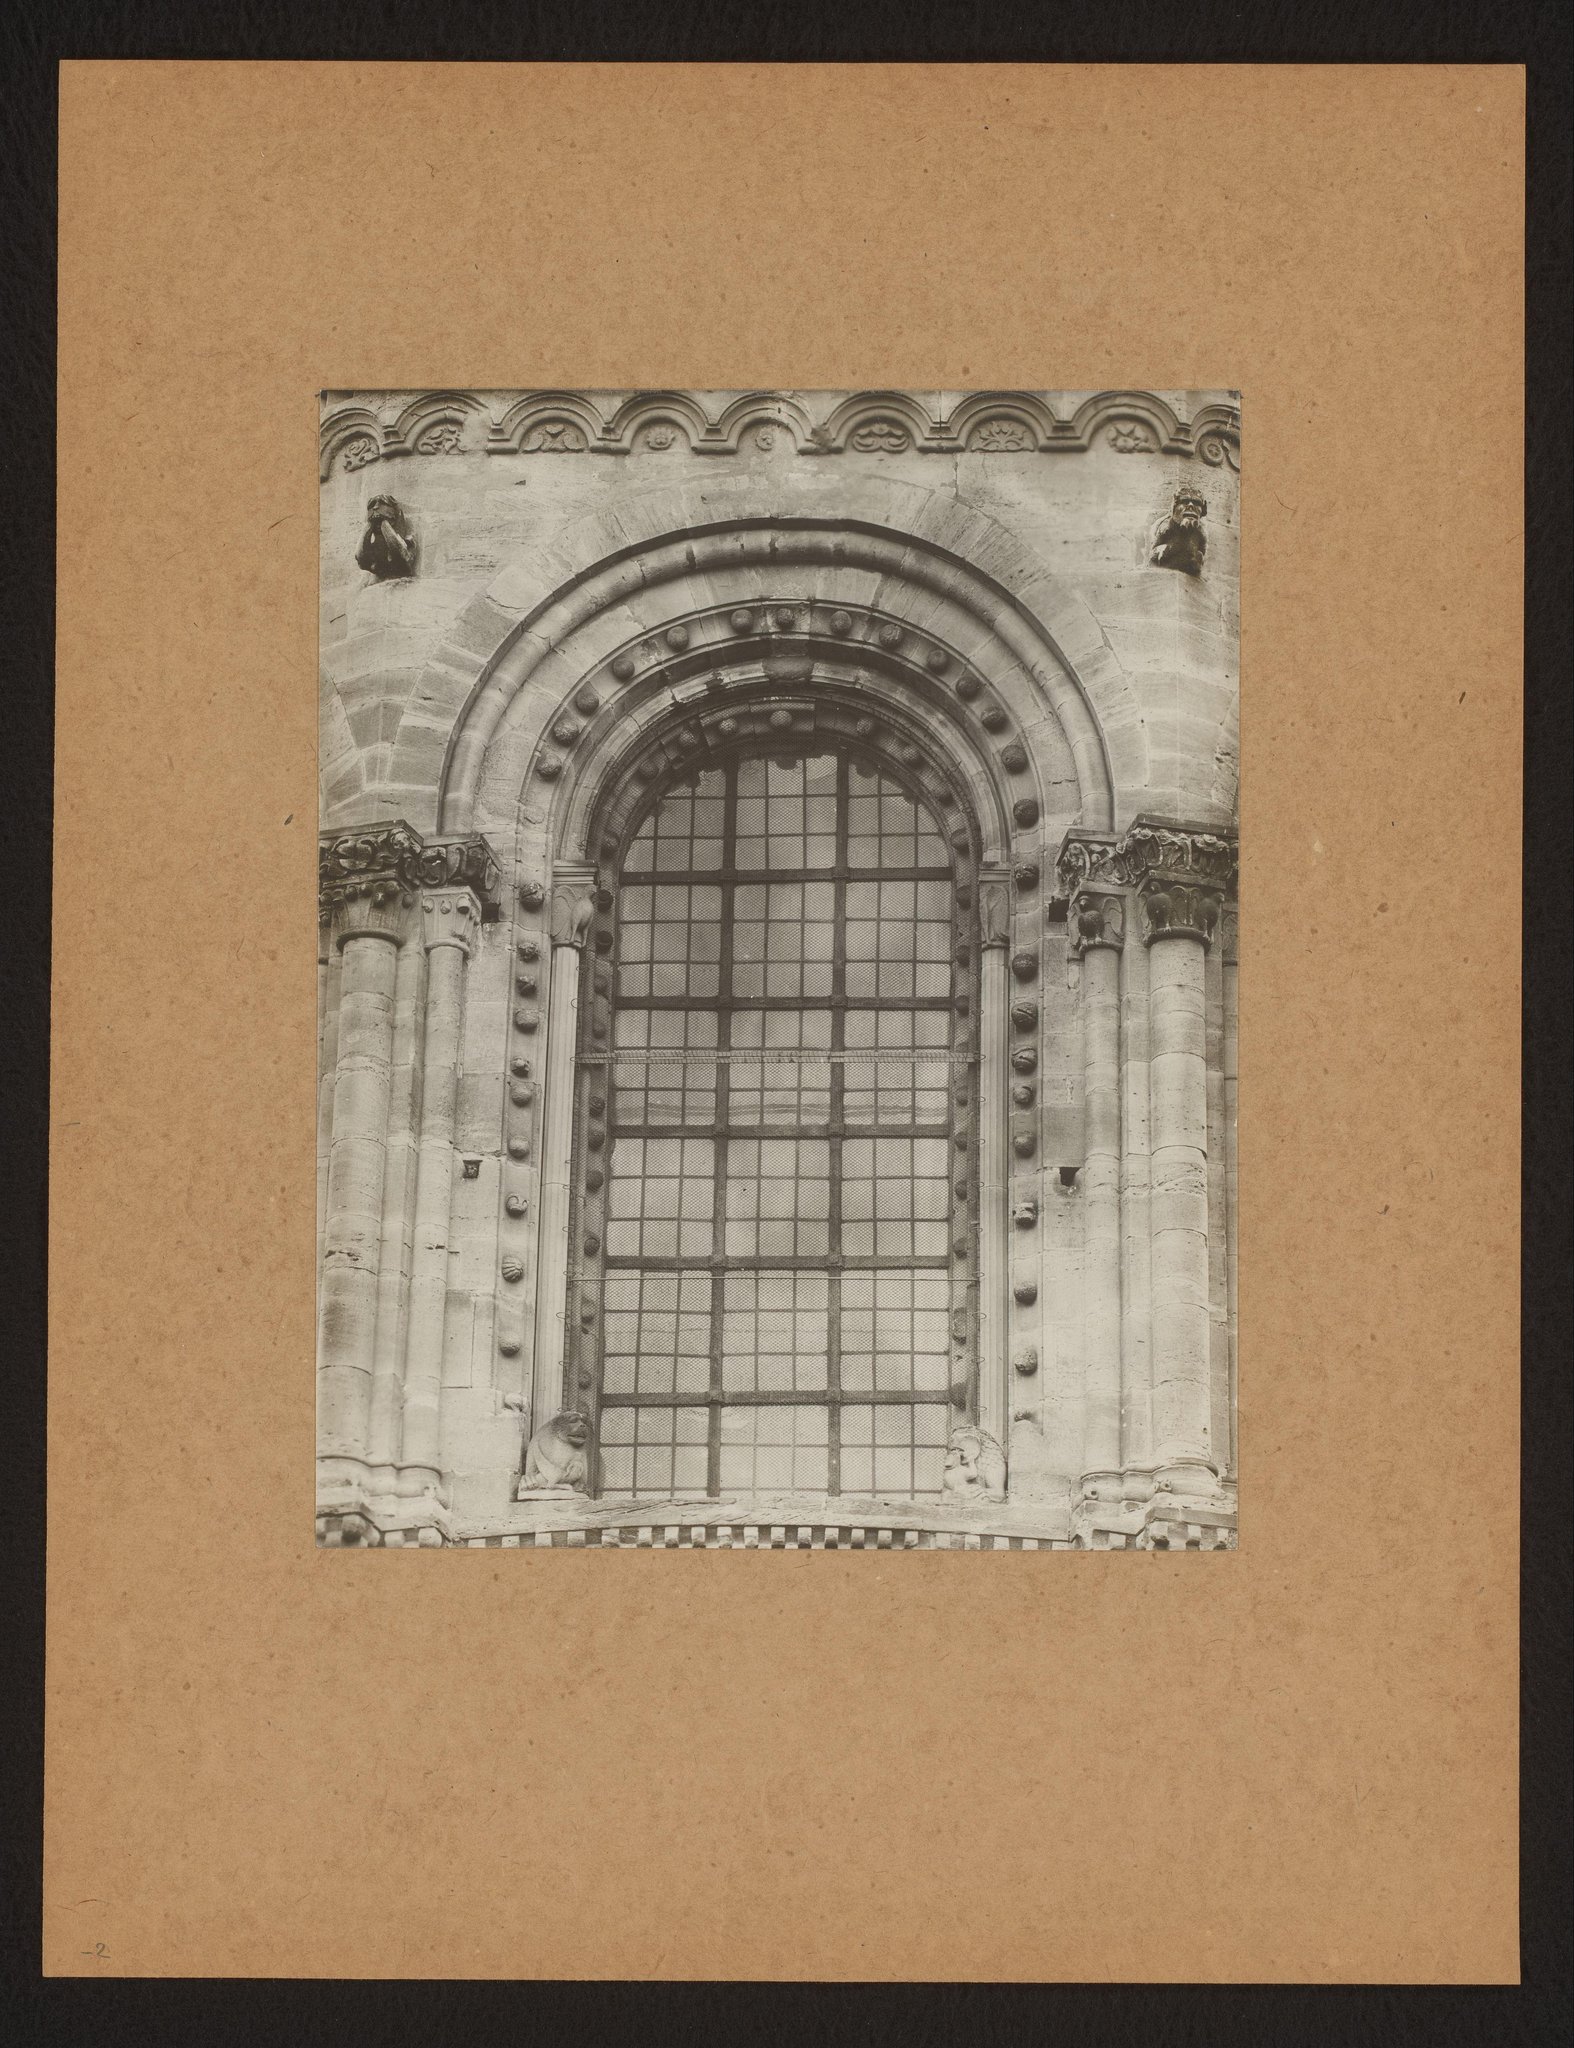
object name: photograph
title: Gezicht op een venster in de dom van Bamberg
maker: Anonymous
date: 1900-1920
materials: paper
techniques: gelatin silver print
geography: bamberg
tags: church (exterior)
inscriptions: number: ‘2’